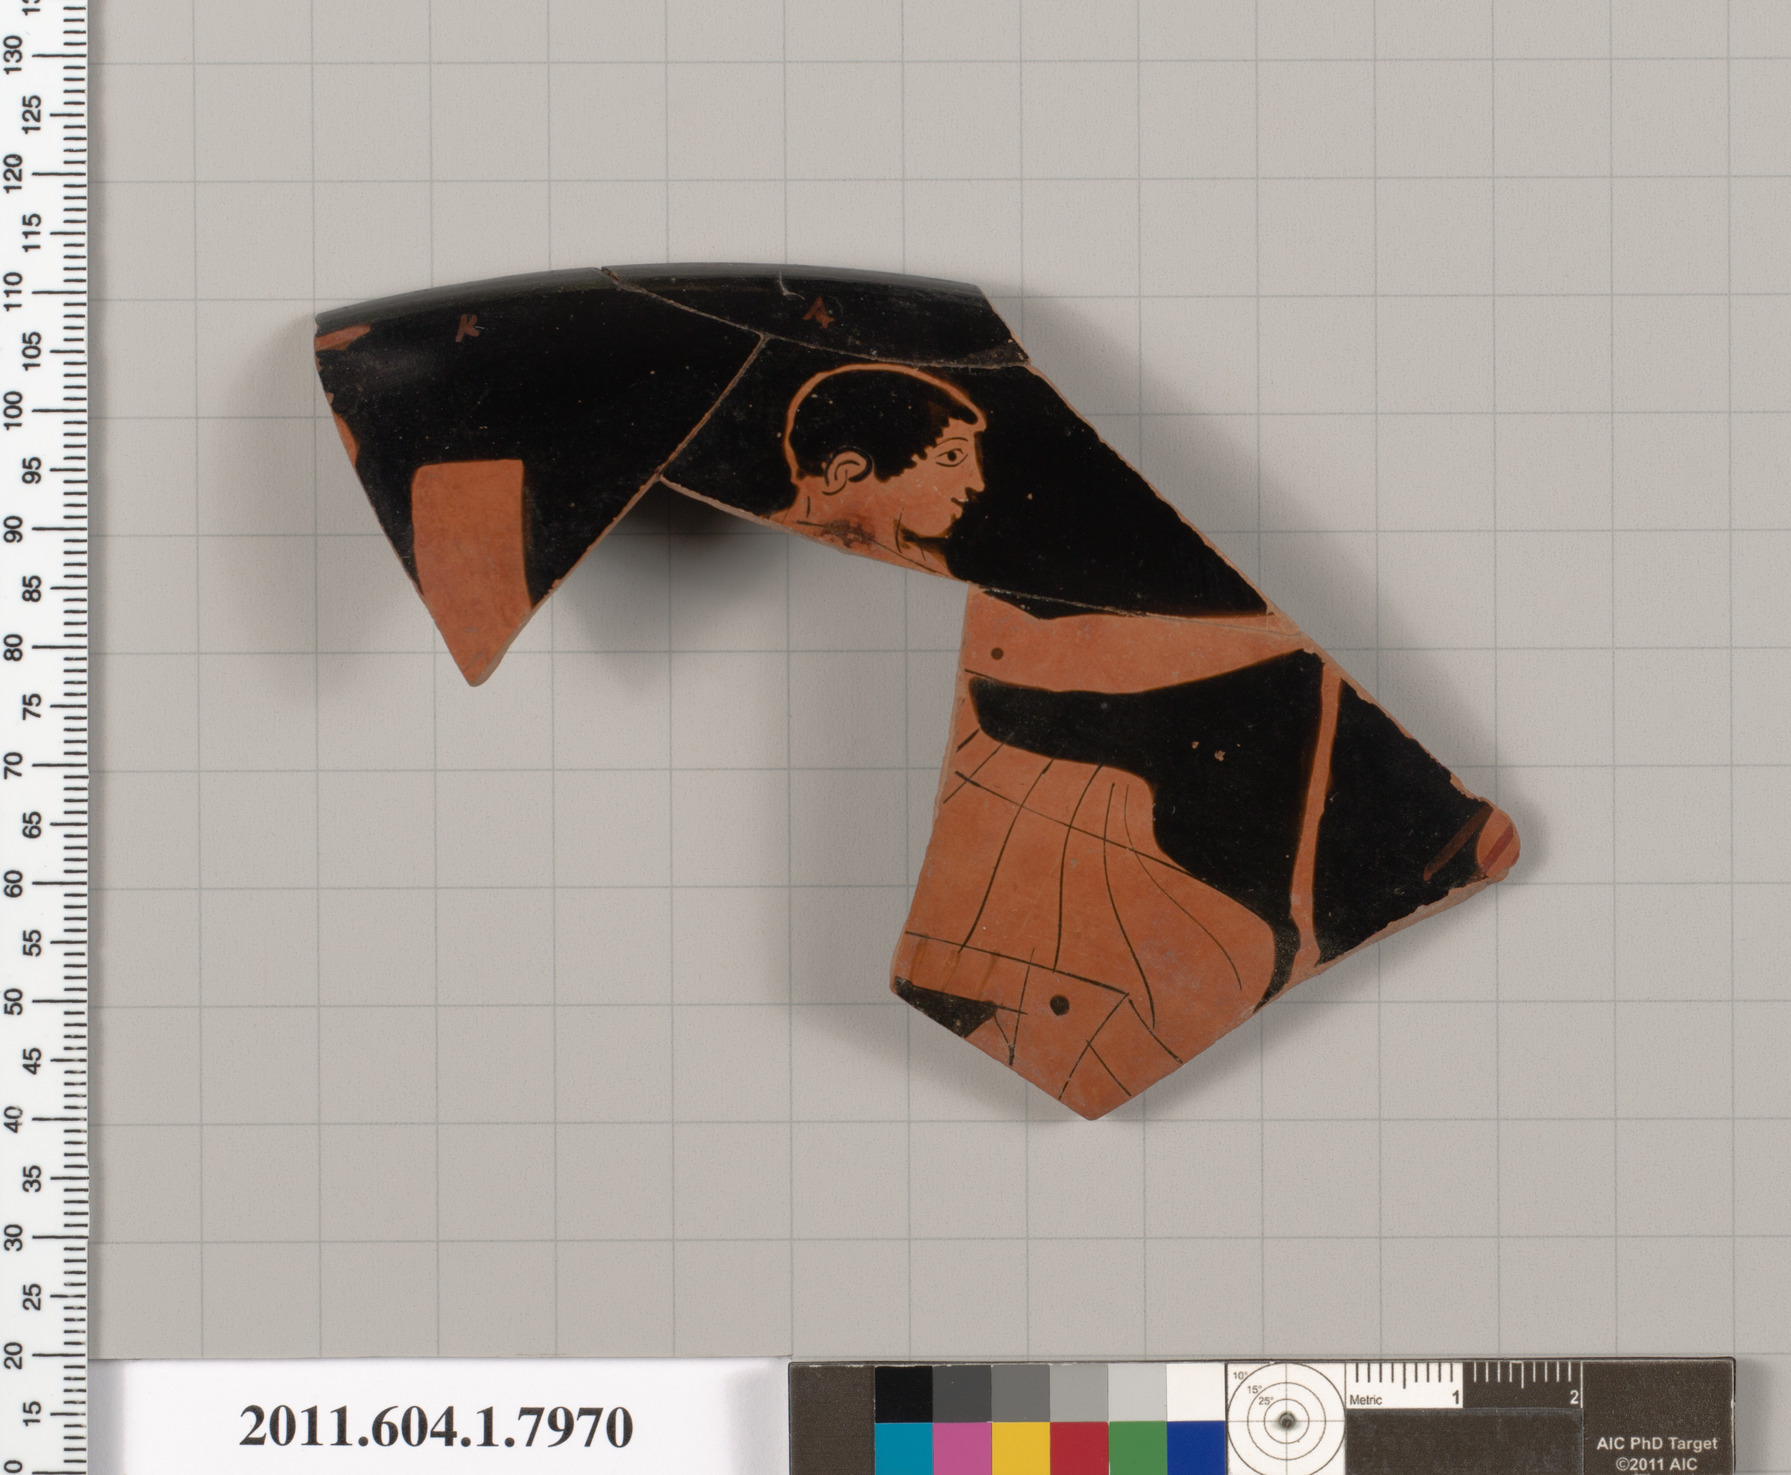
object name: kylix fragment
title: Terracotta rim fragment of a kylix (drinking cup)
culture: greek, attic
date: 460-450 BCE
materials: terracotta